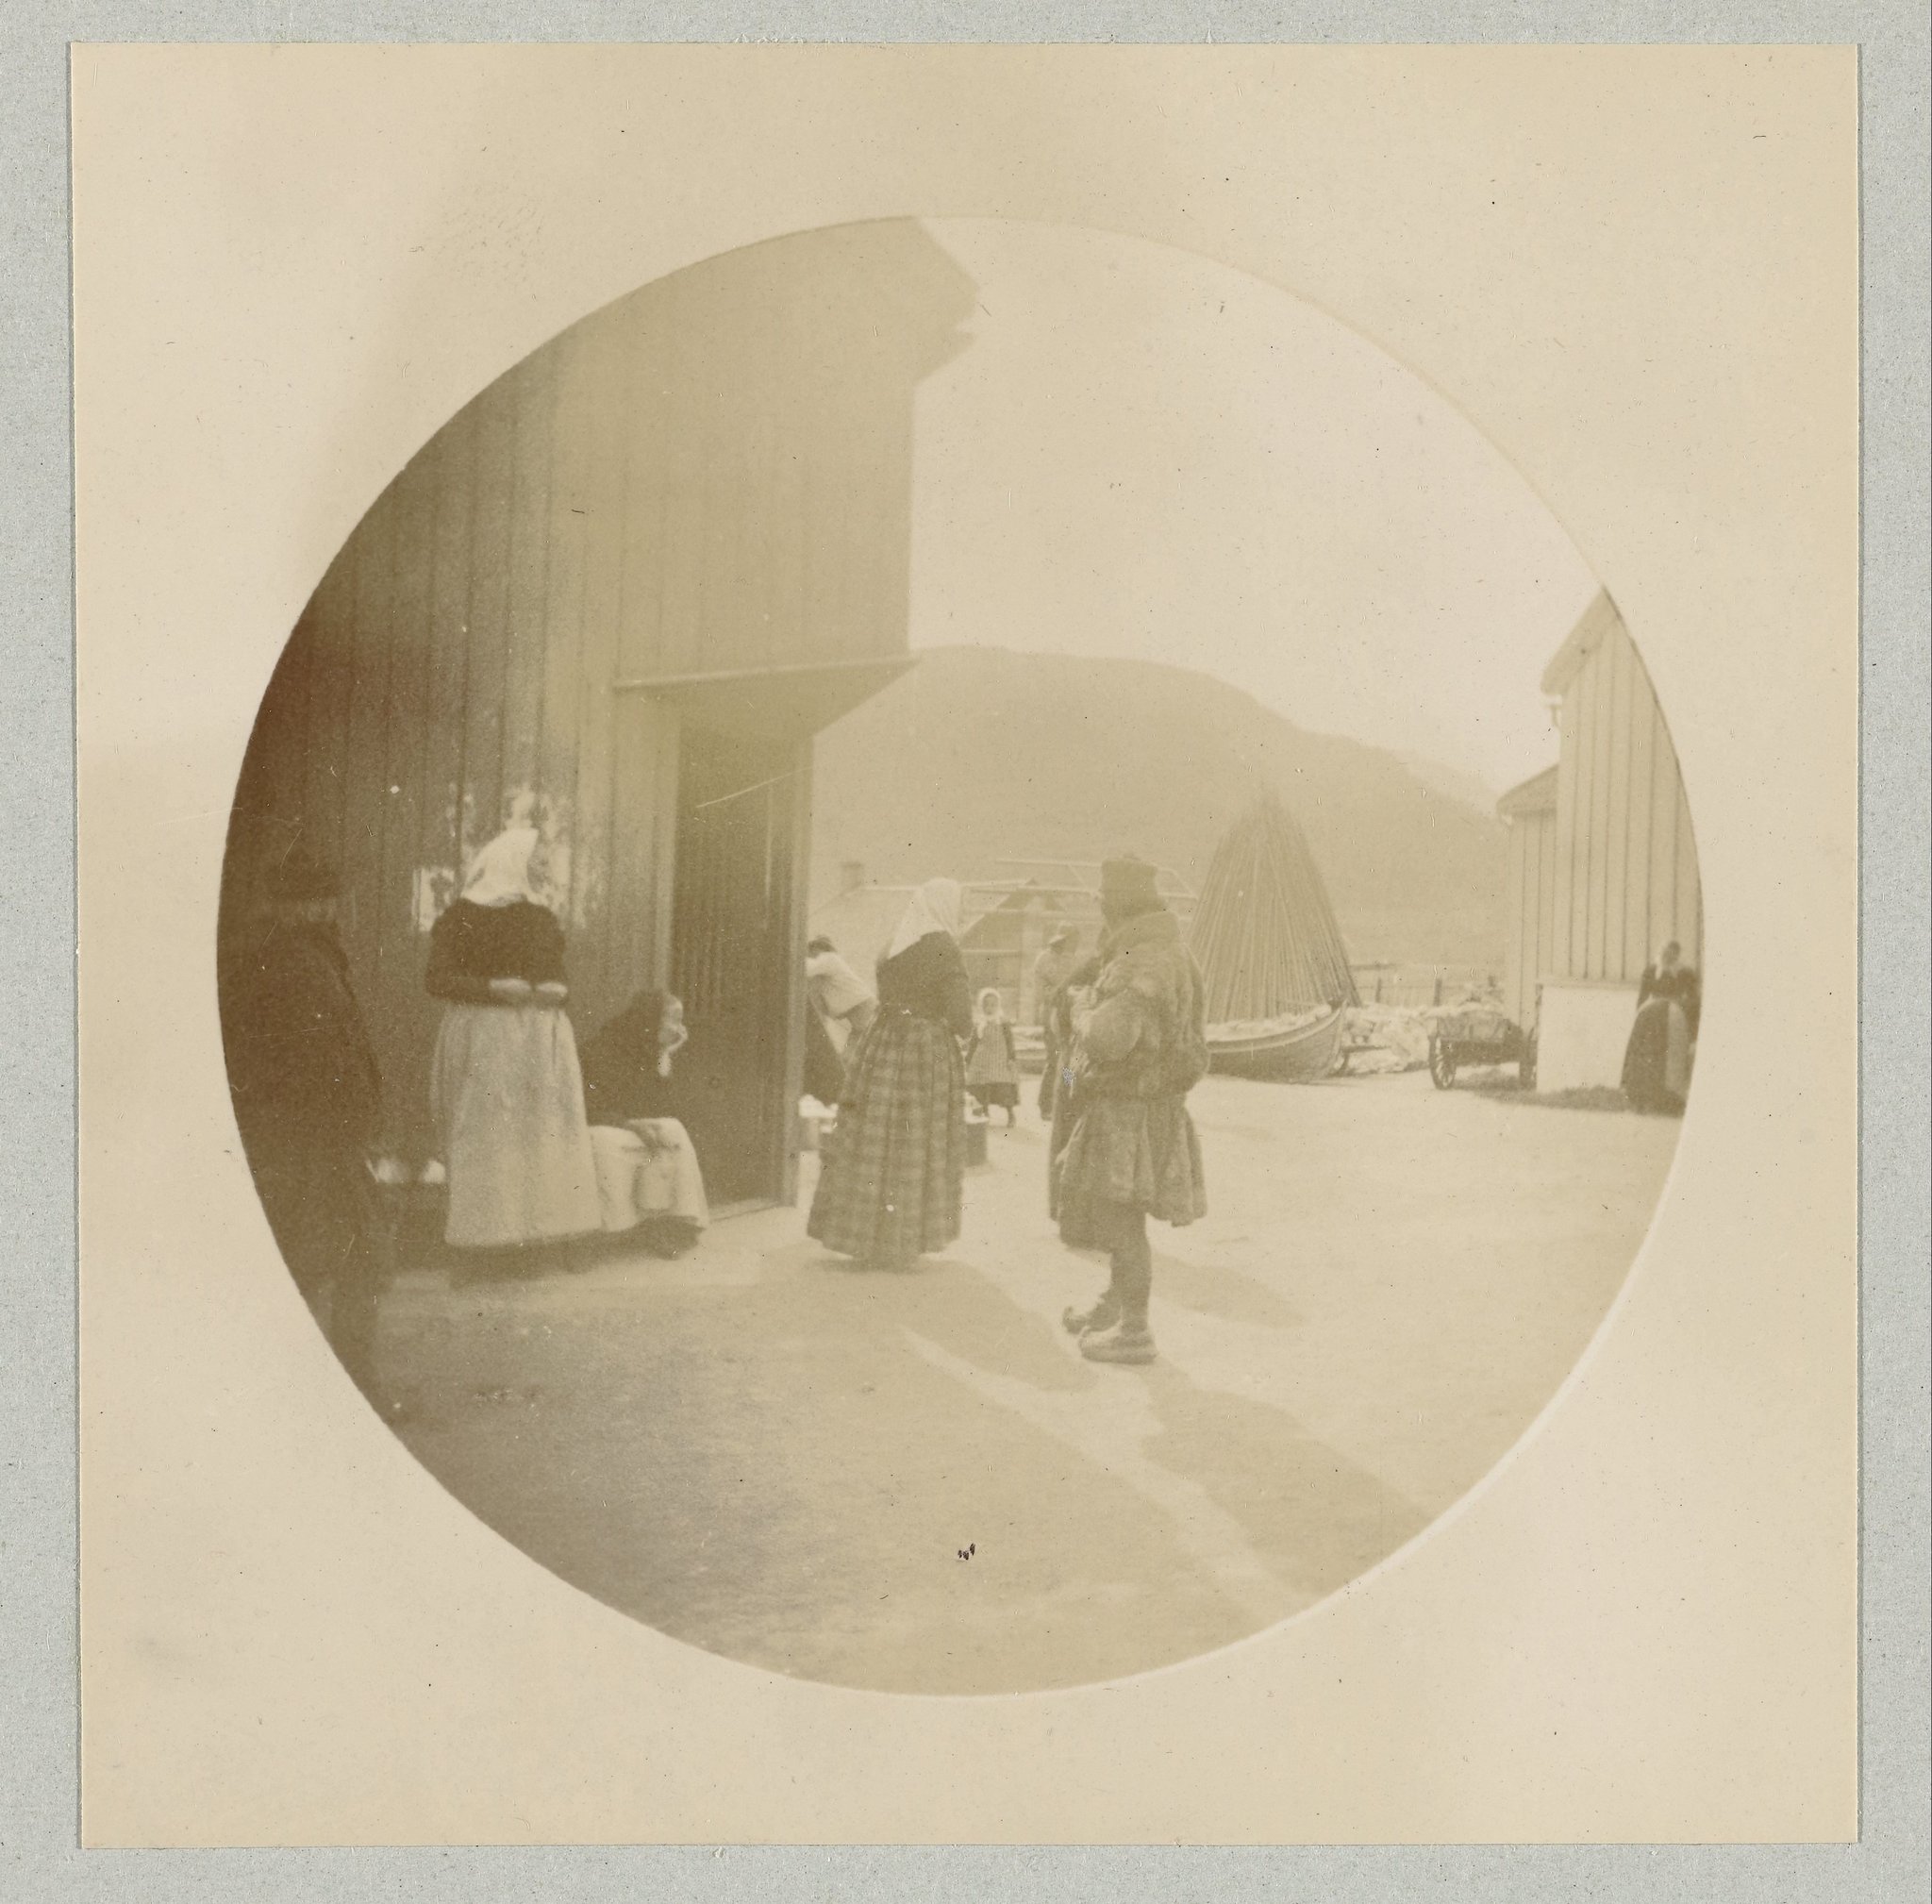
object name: photograph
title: Am Nordcap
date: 1807-1889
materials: cardboard, paper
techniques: gelatin silver print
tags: norway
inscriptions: number: ‘28’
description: De afdruk van de foto is rond, het papier vierkant. foto gemaakt met Nr. 1 Kodak Camera